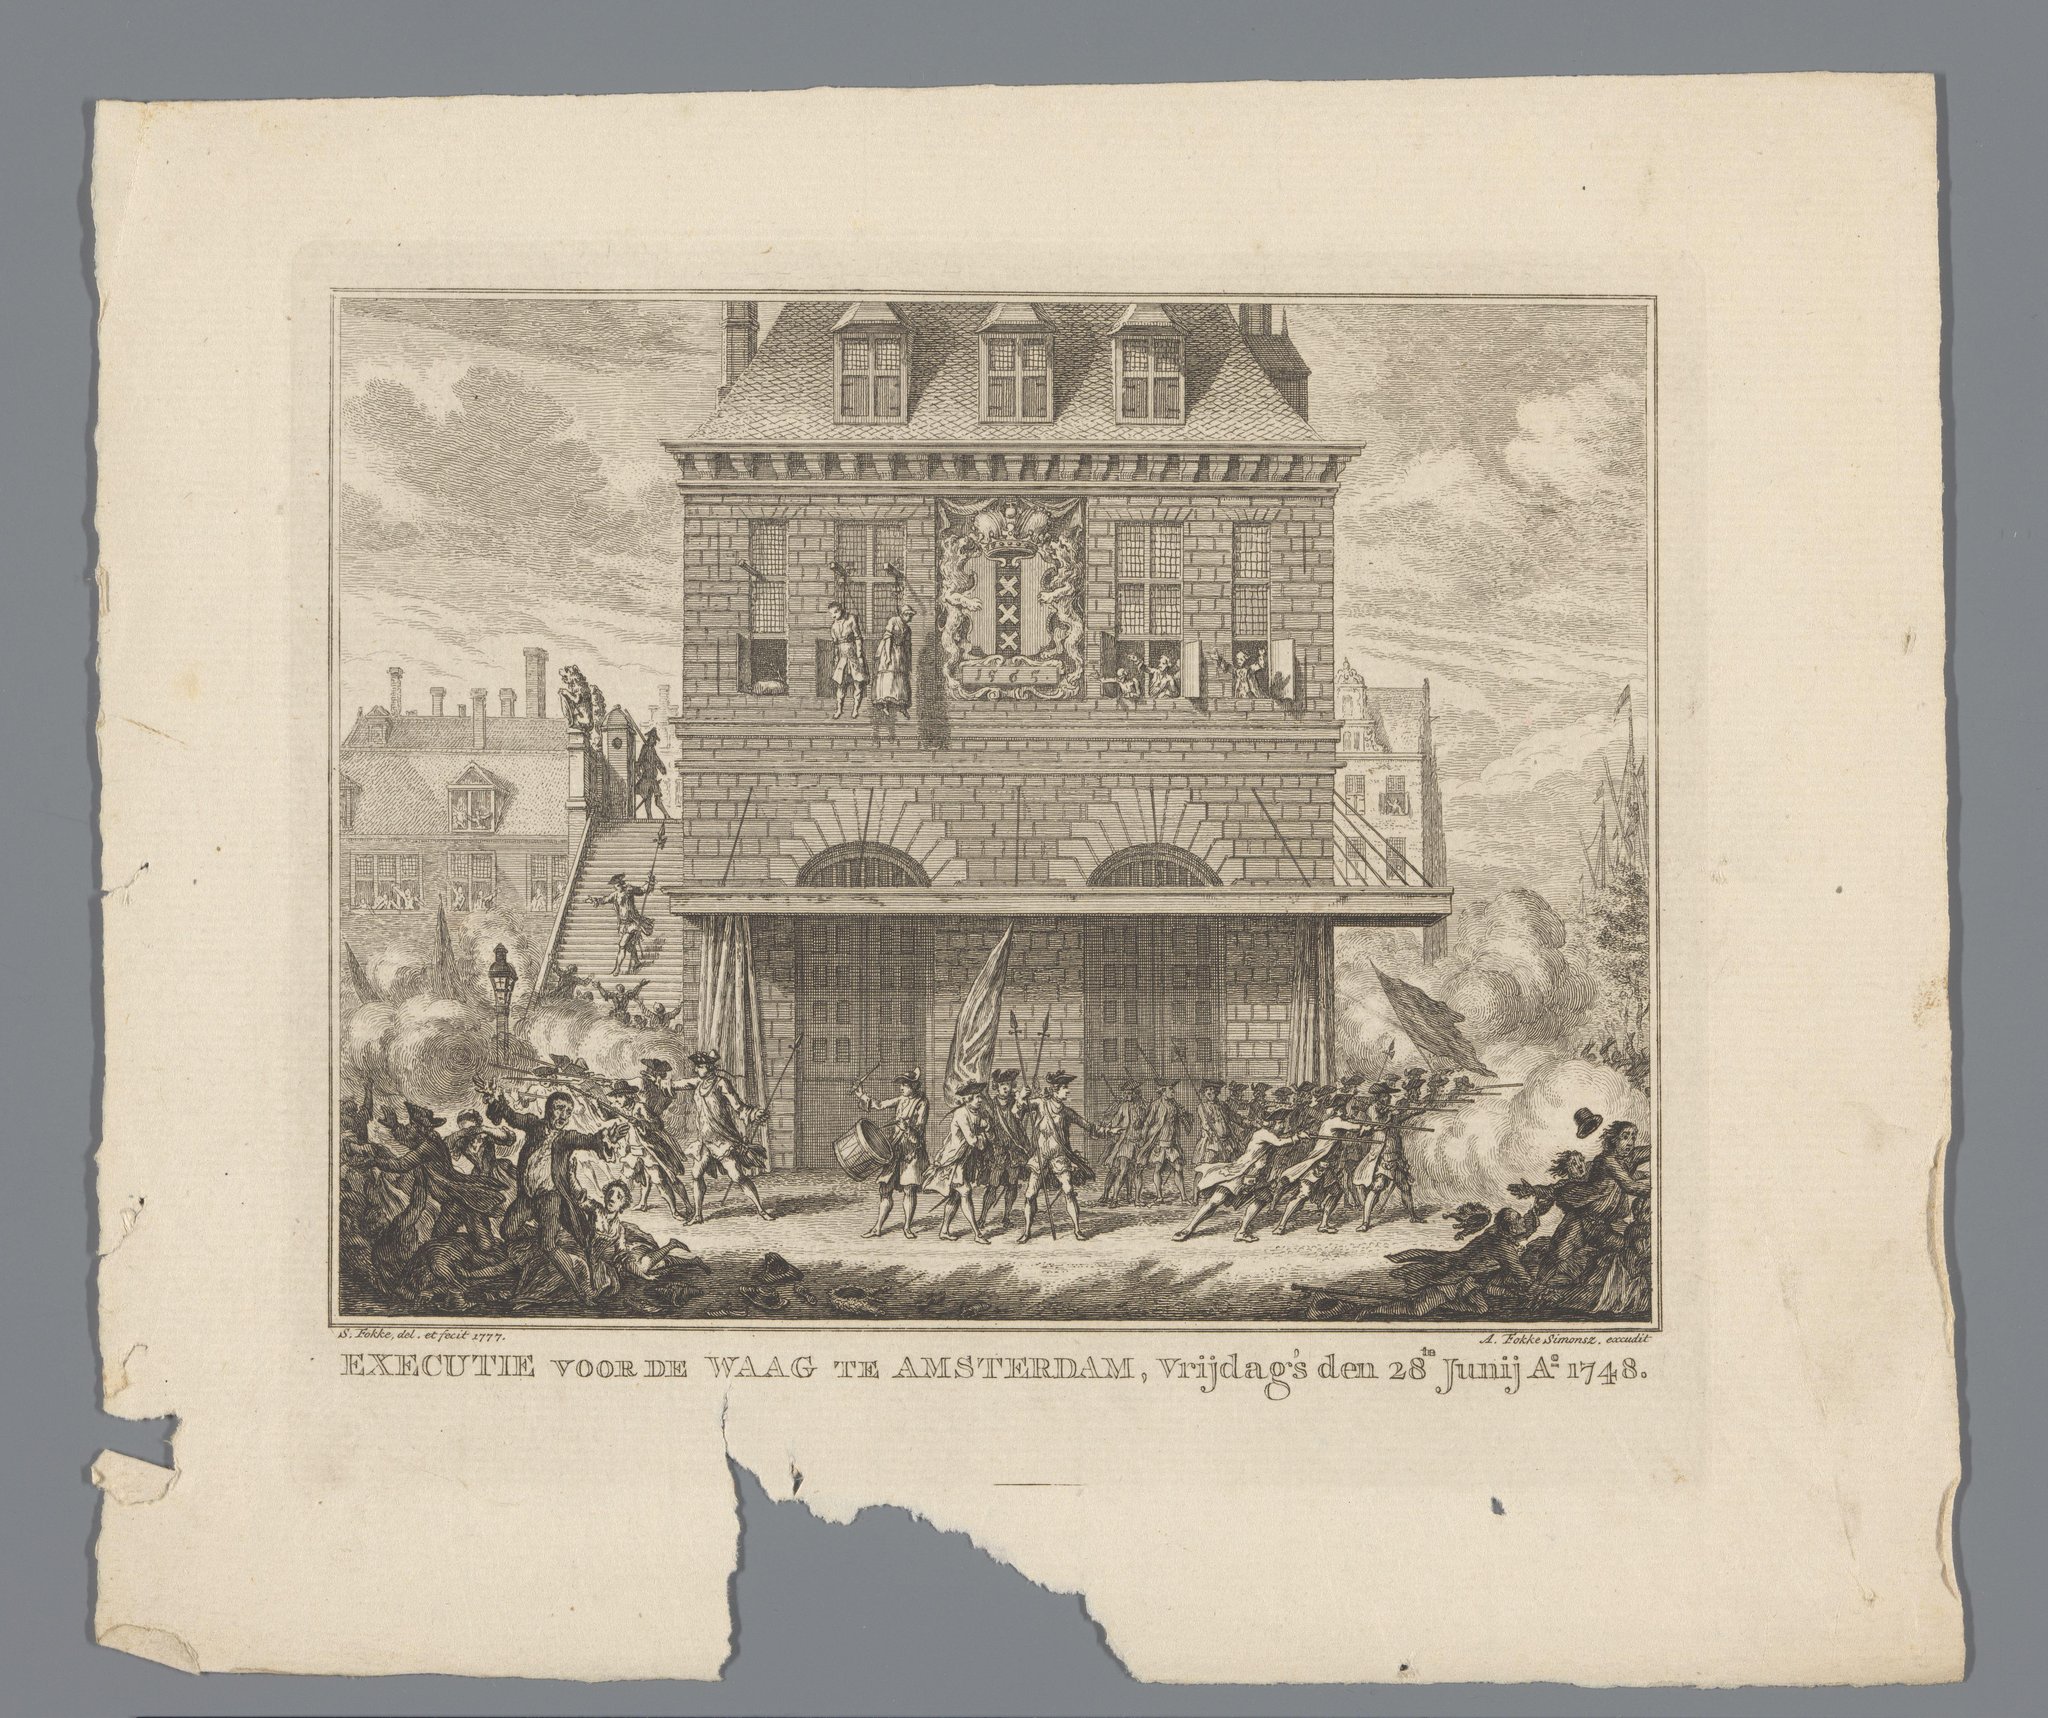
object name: book illustration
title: Executie voor de Waag te Amsterdam, vrijdags den 28e junij ao 1748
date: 1777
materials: paper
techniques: engraving, etching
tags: violent death by hanging, death penalty, execution, street-fights, riots, law and jurisprudence (+ execution)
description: Piet van Dort, die zich de Burgemeester der Plunderaars noemde, en de citroen- en gedroogde scholverkoopster Mat van den Nieuwendijk zijn opgehangen aan de Waag te Amsterdam. Beiden waren deelnemers aan het Pachtersoproer. De schutterij opent het vuur op de toeschouwers.